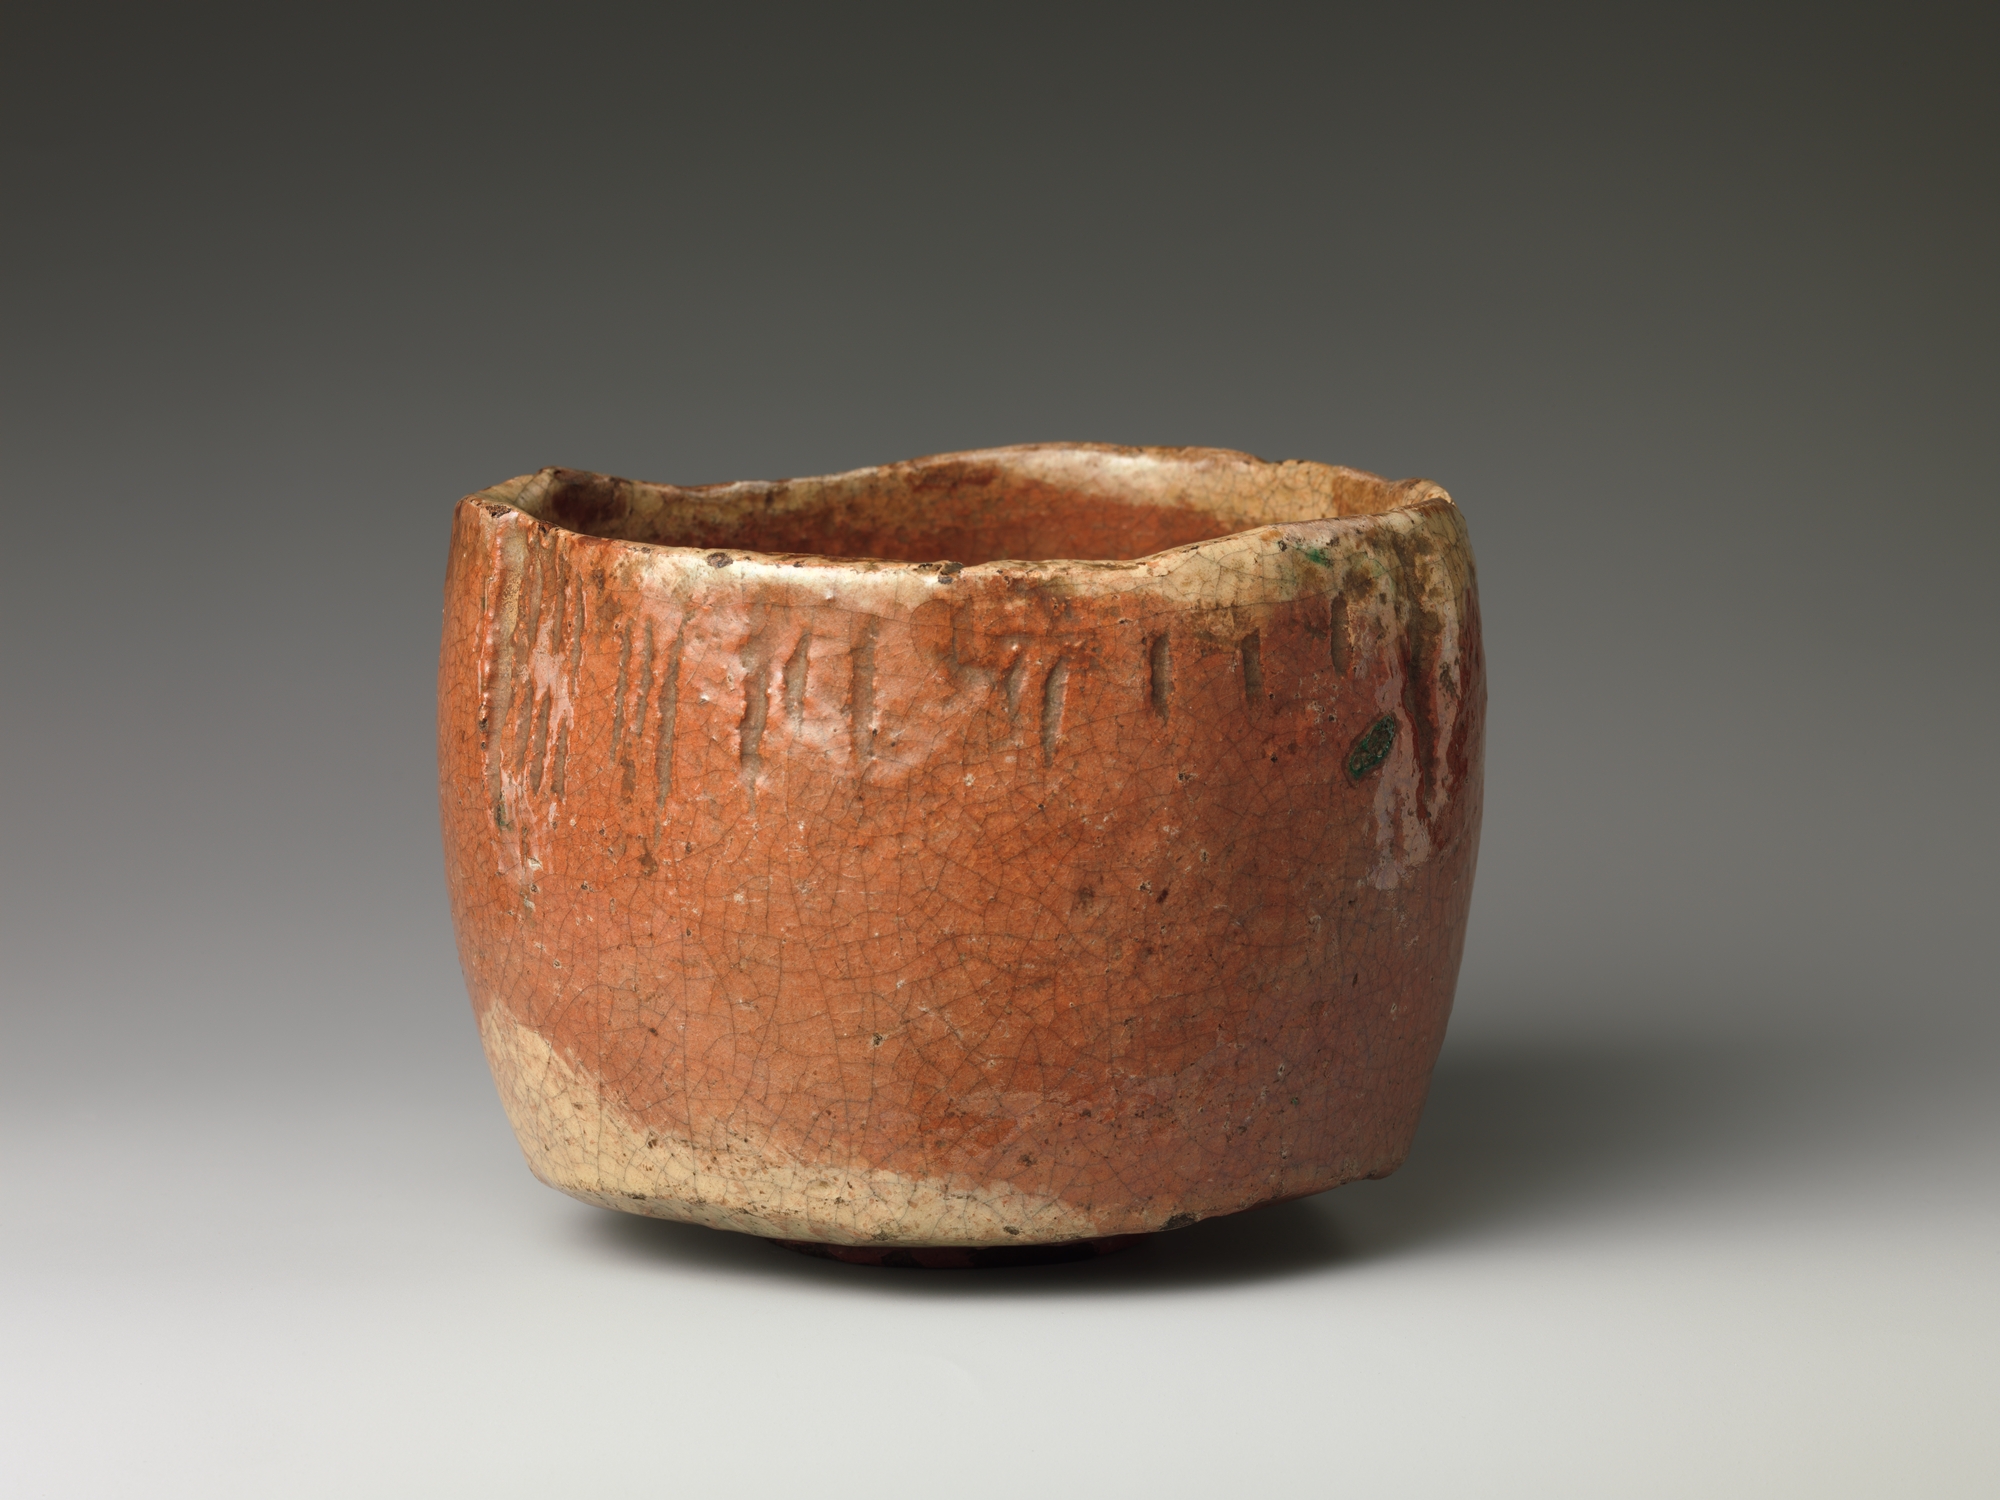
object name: teabowl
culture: japanese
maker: hon'ami kōetsu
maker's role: artist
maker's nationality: japanese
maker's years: 1558-1637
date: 1601-1700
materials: clay, glaze